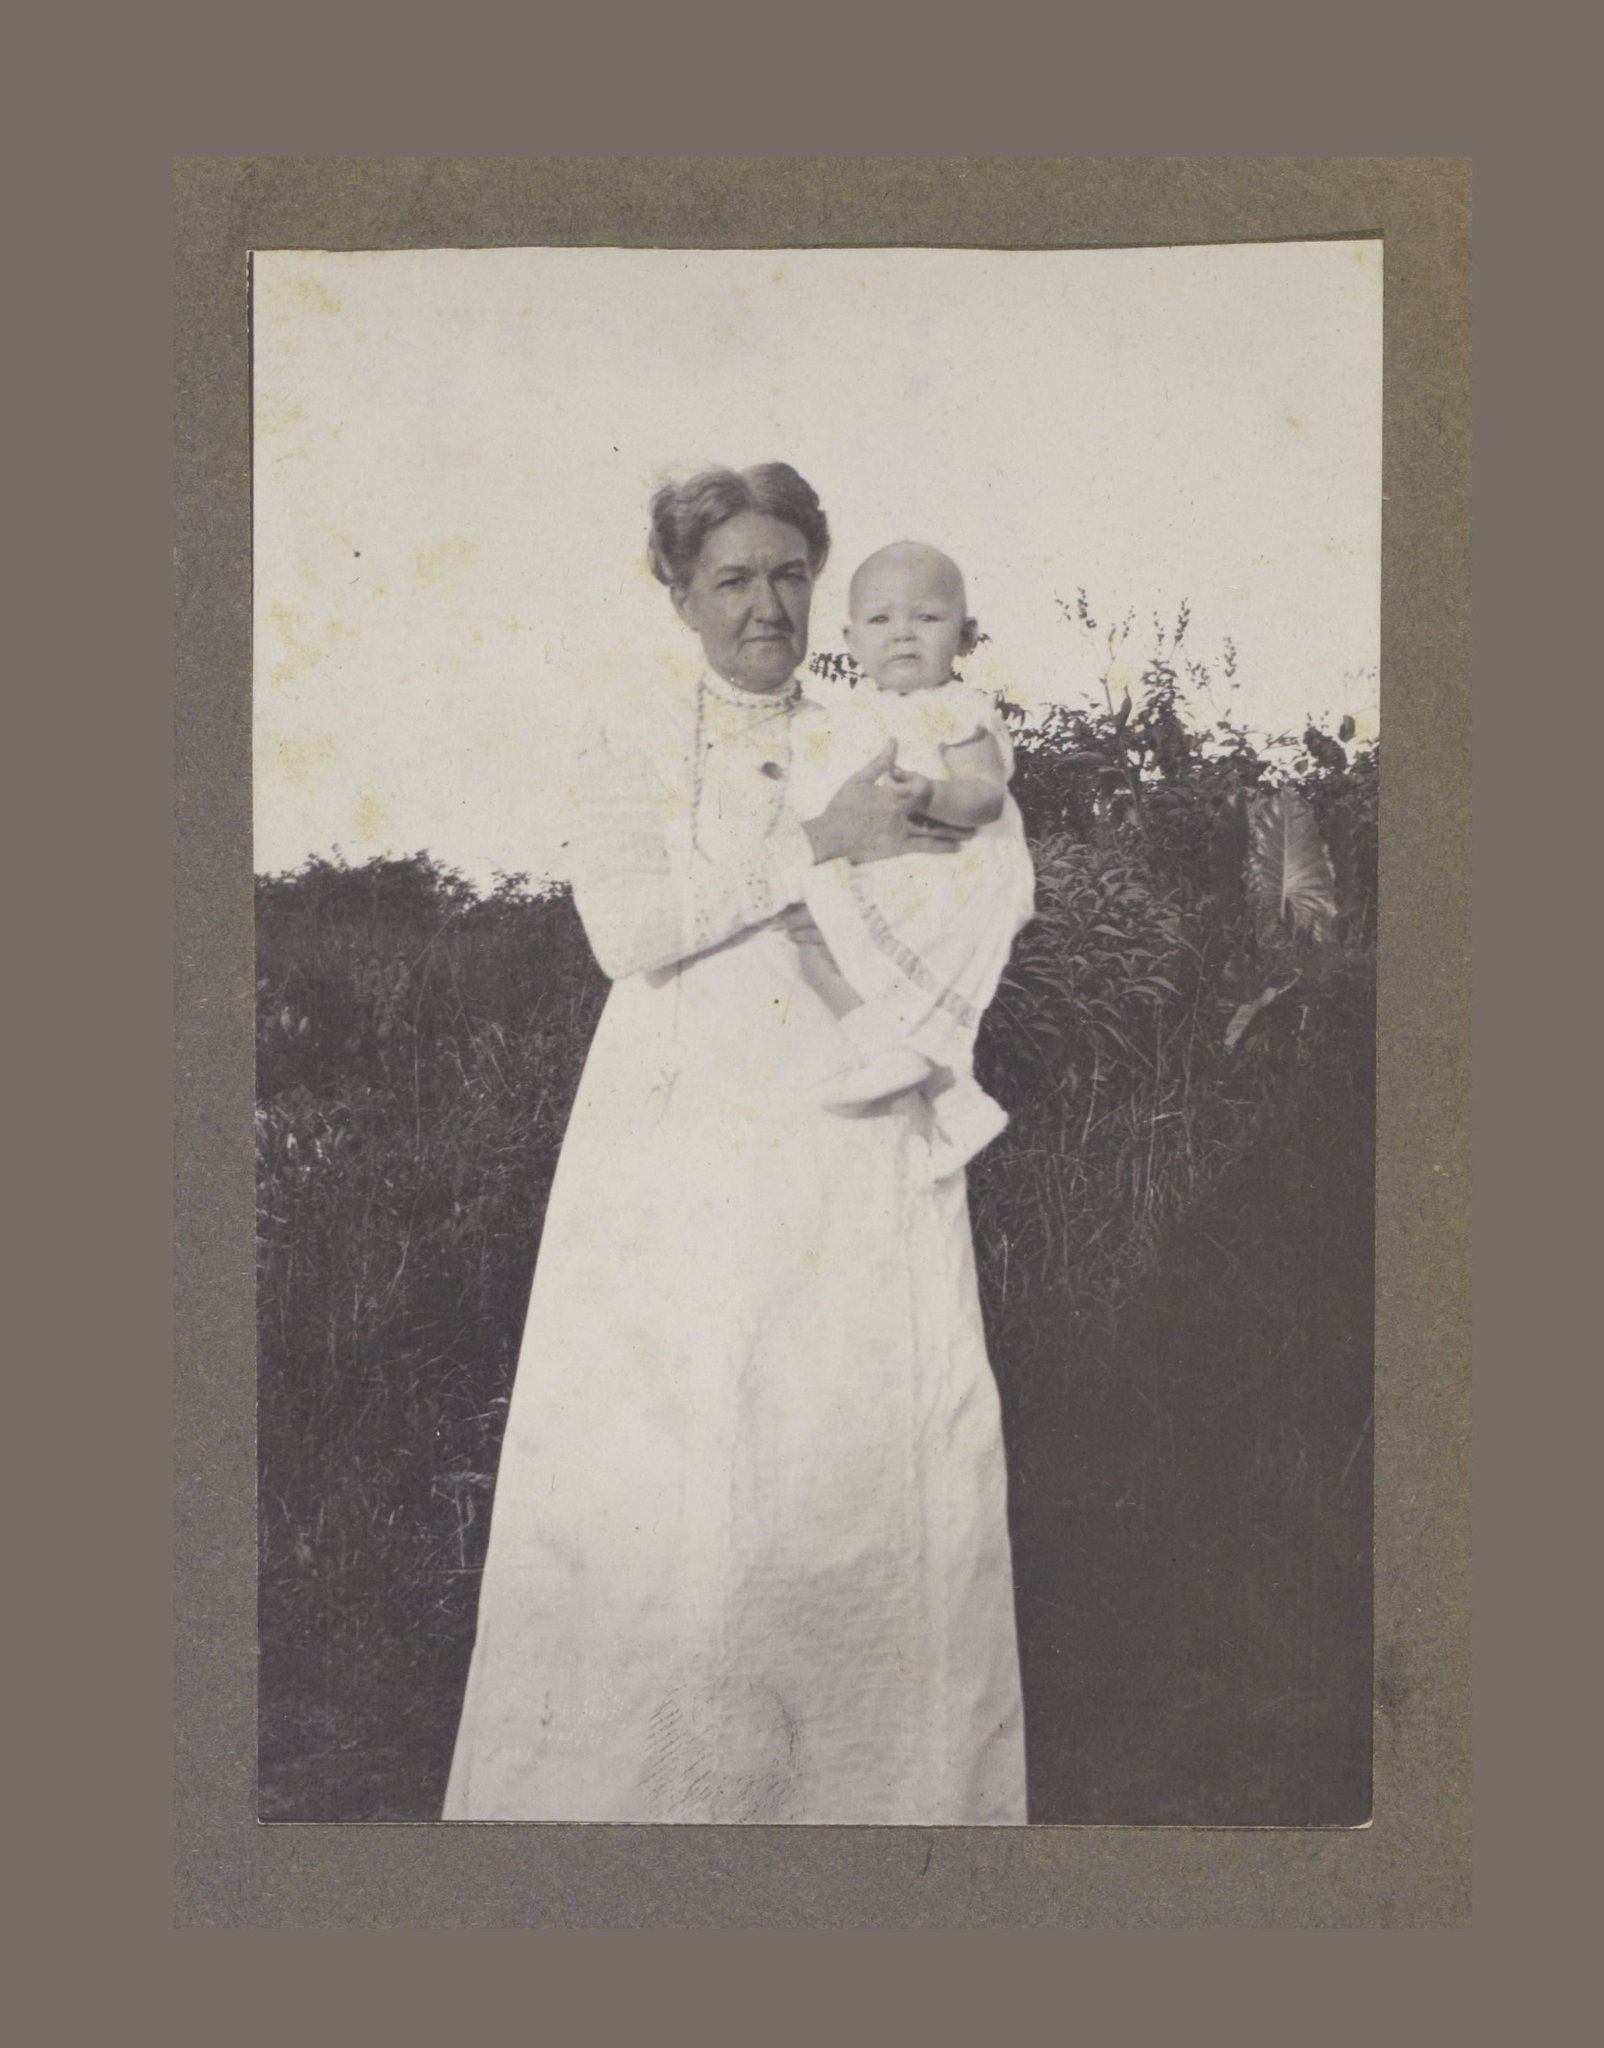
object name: photograph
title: Anna Gonggrijp-Rühmann, staande met een kind op de arm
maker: Anonymous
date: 1912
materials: photographic support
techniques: photography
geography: suriname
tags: suriname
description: Anna Gonggrijp-Rühmann, staande met een kind op de arm. Onderdeel van het fotoalbum over het leven van de familie Gonggrijp in Suriname rond 1912.